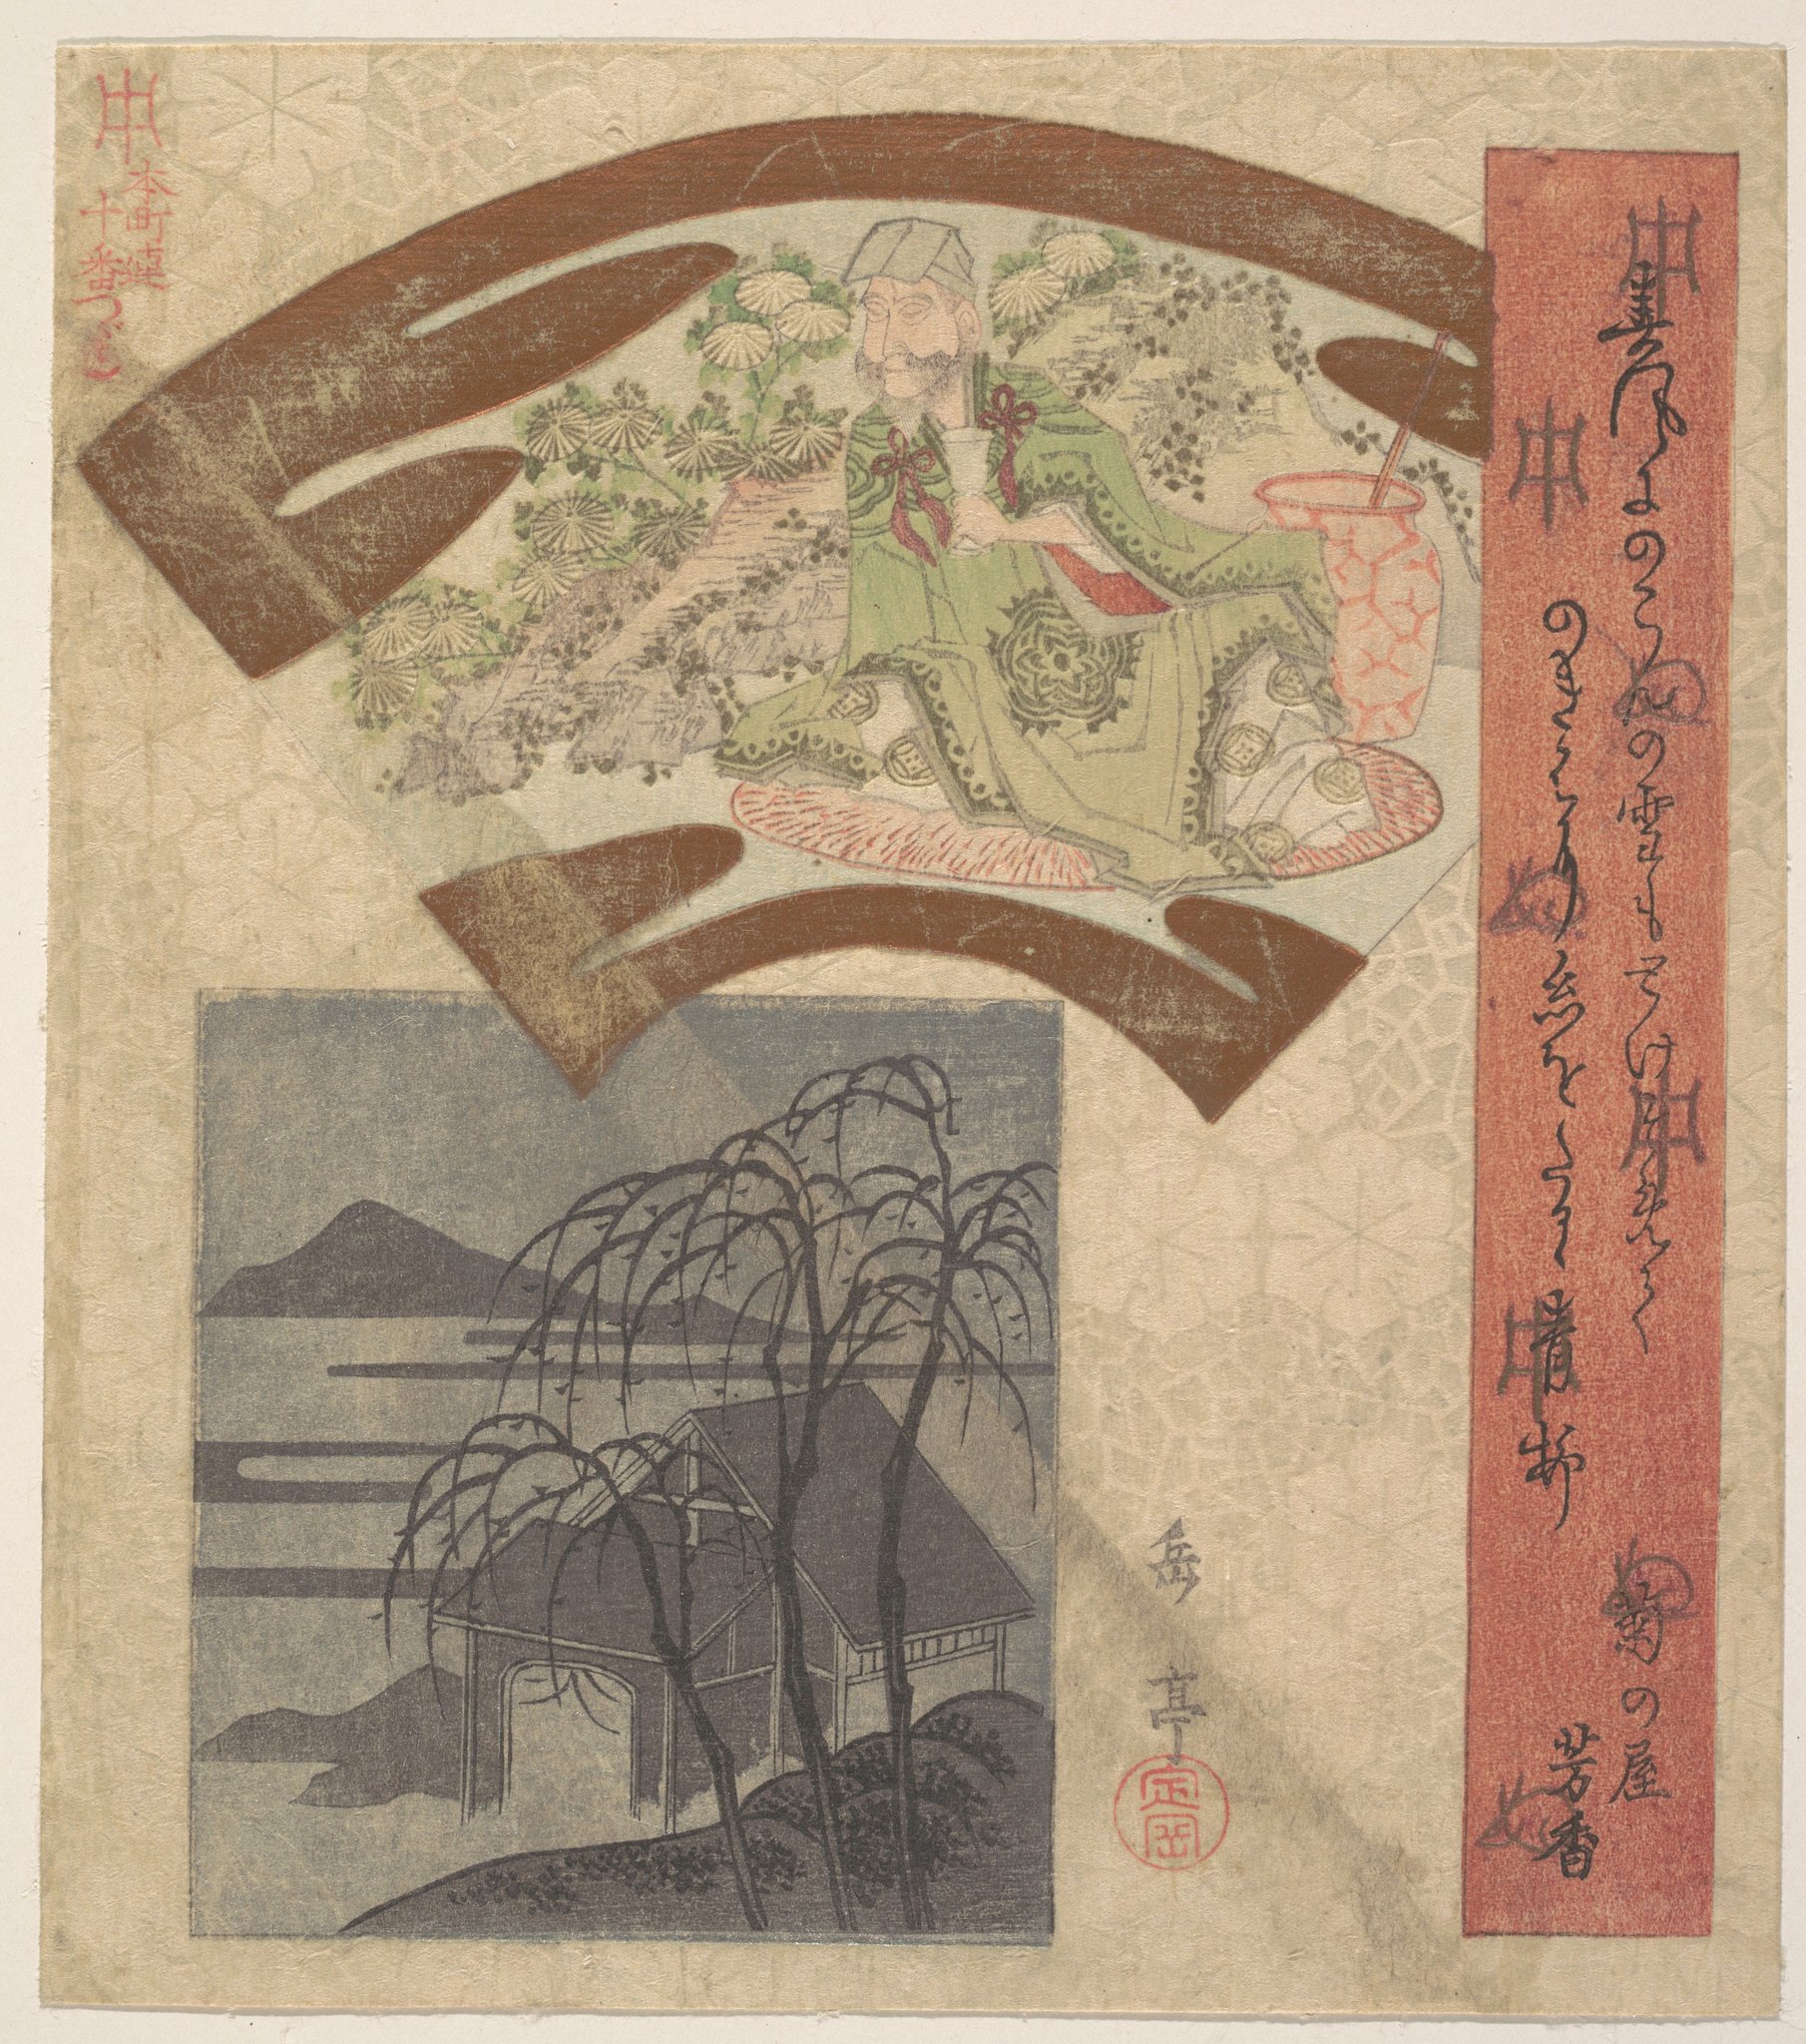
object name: print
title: Fan-shaped Design Depicting Chinese Poet or Philosopher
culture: japanese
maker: yashima gakutei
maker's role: artist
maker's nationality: japanese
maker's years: 1786-1868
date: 1786-1868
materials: ink, paper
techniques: surimono, woodblock print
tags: men,landscapes